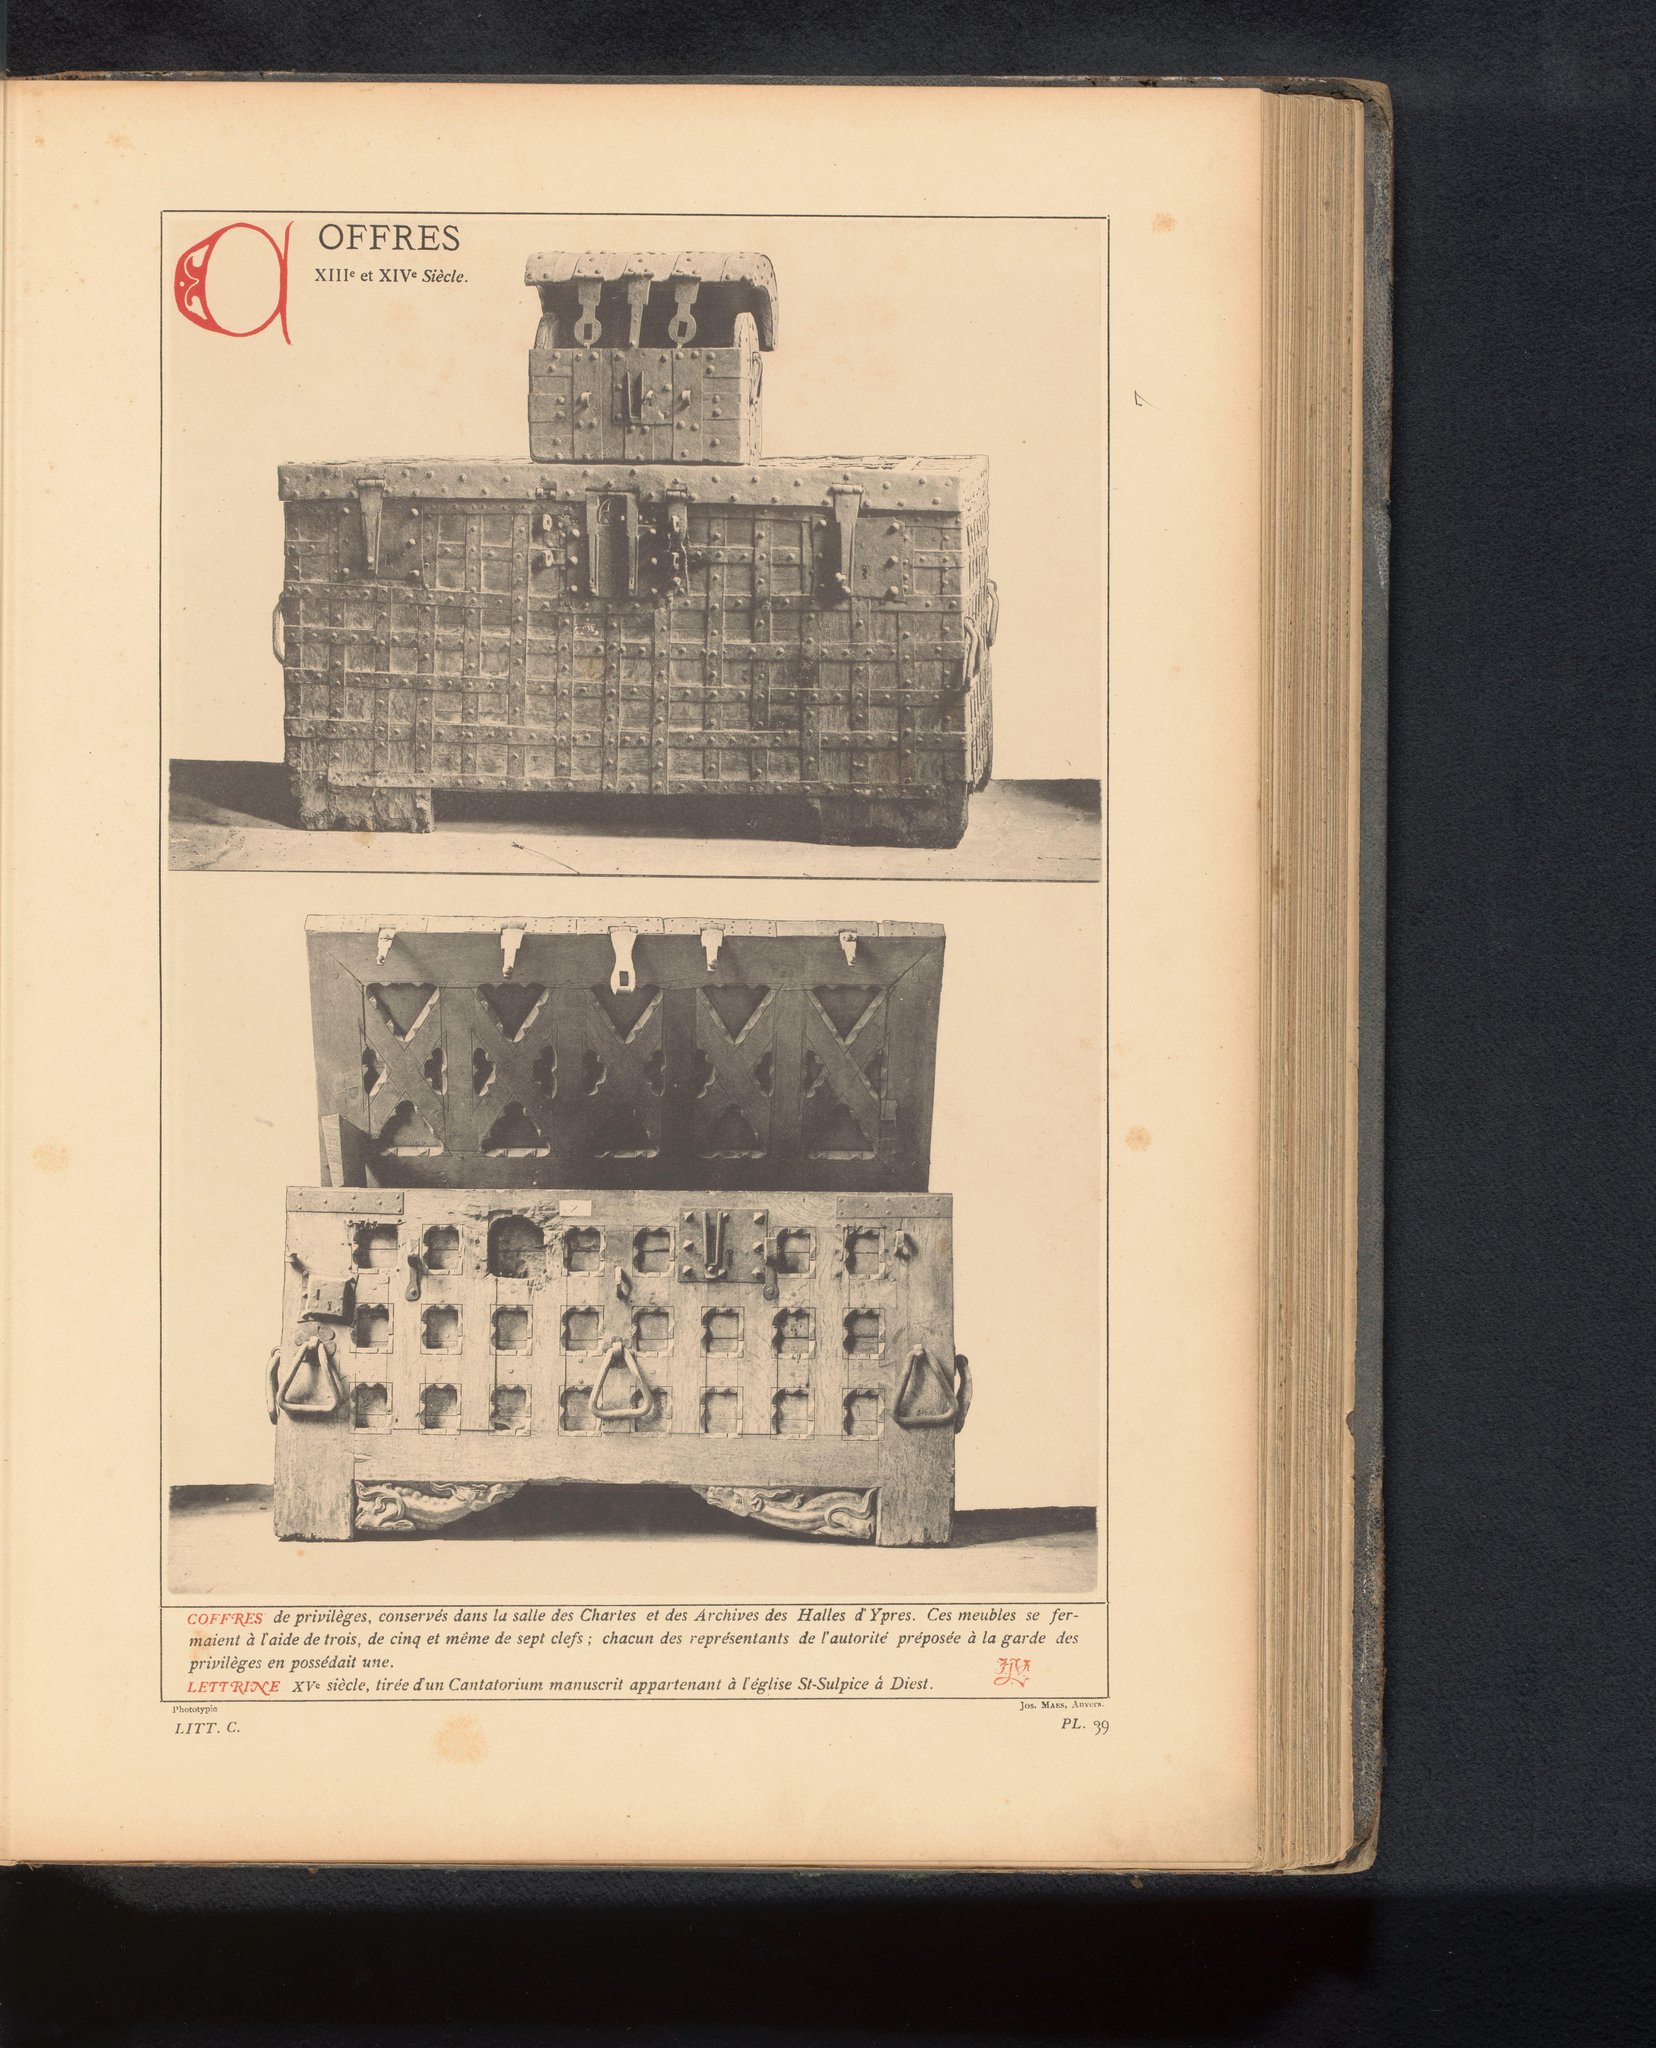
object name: photomechanical print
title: Twee opnames van houten koffers met ijzeren beslag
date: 1875-1880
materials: paper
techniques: photograph, photolithography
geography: antwerp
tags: chest, coffer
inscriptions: inscription: ‘Coffres de privilèges (...)’, monogram: ‘JJvY’, inscription: ‘LITT. C. - PL. 39’